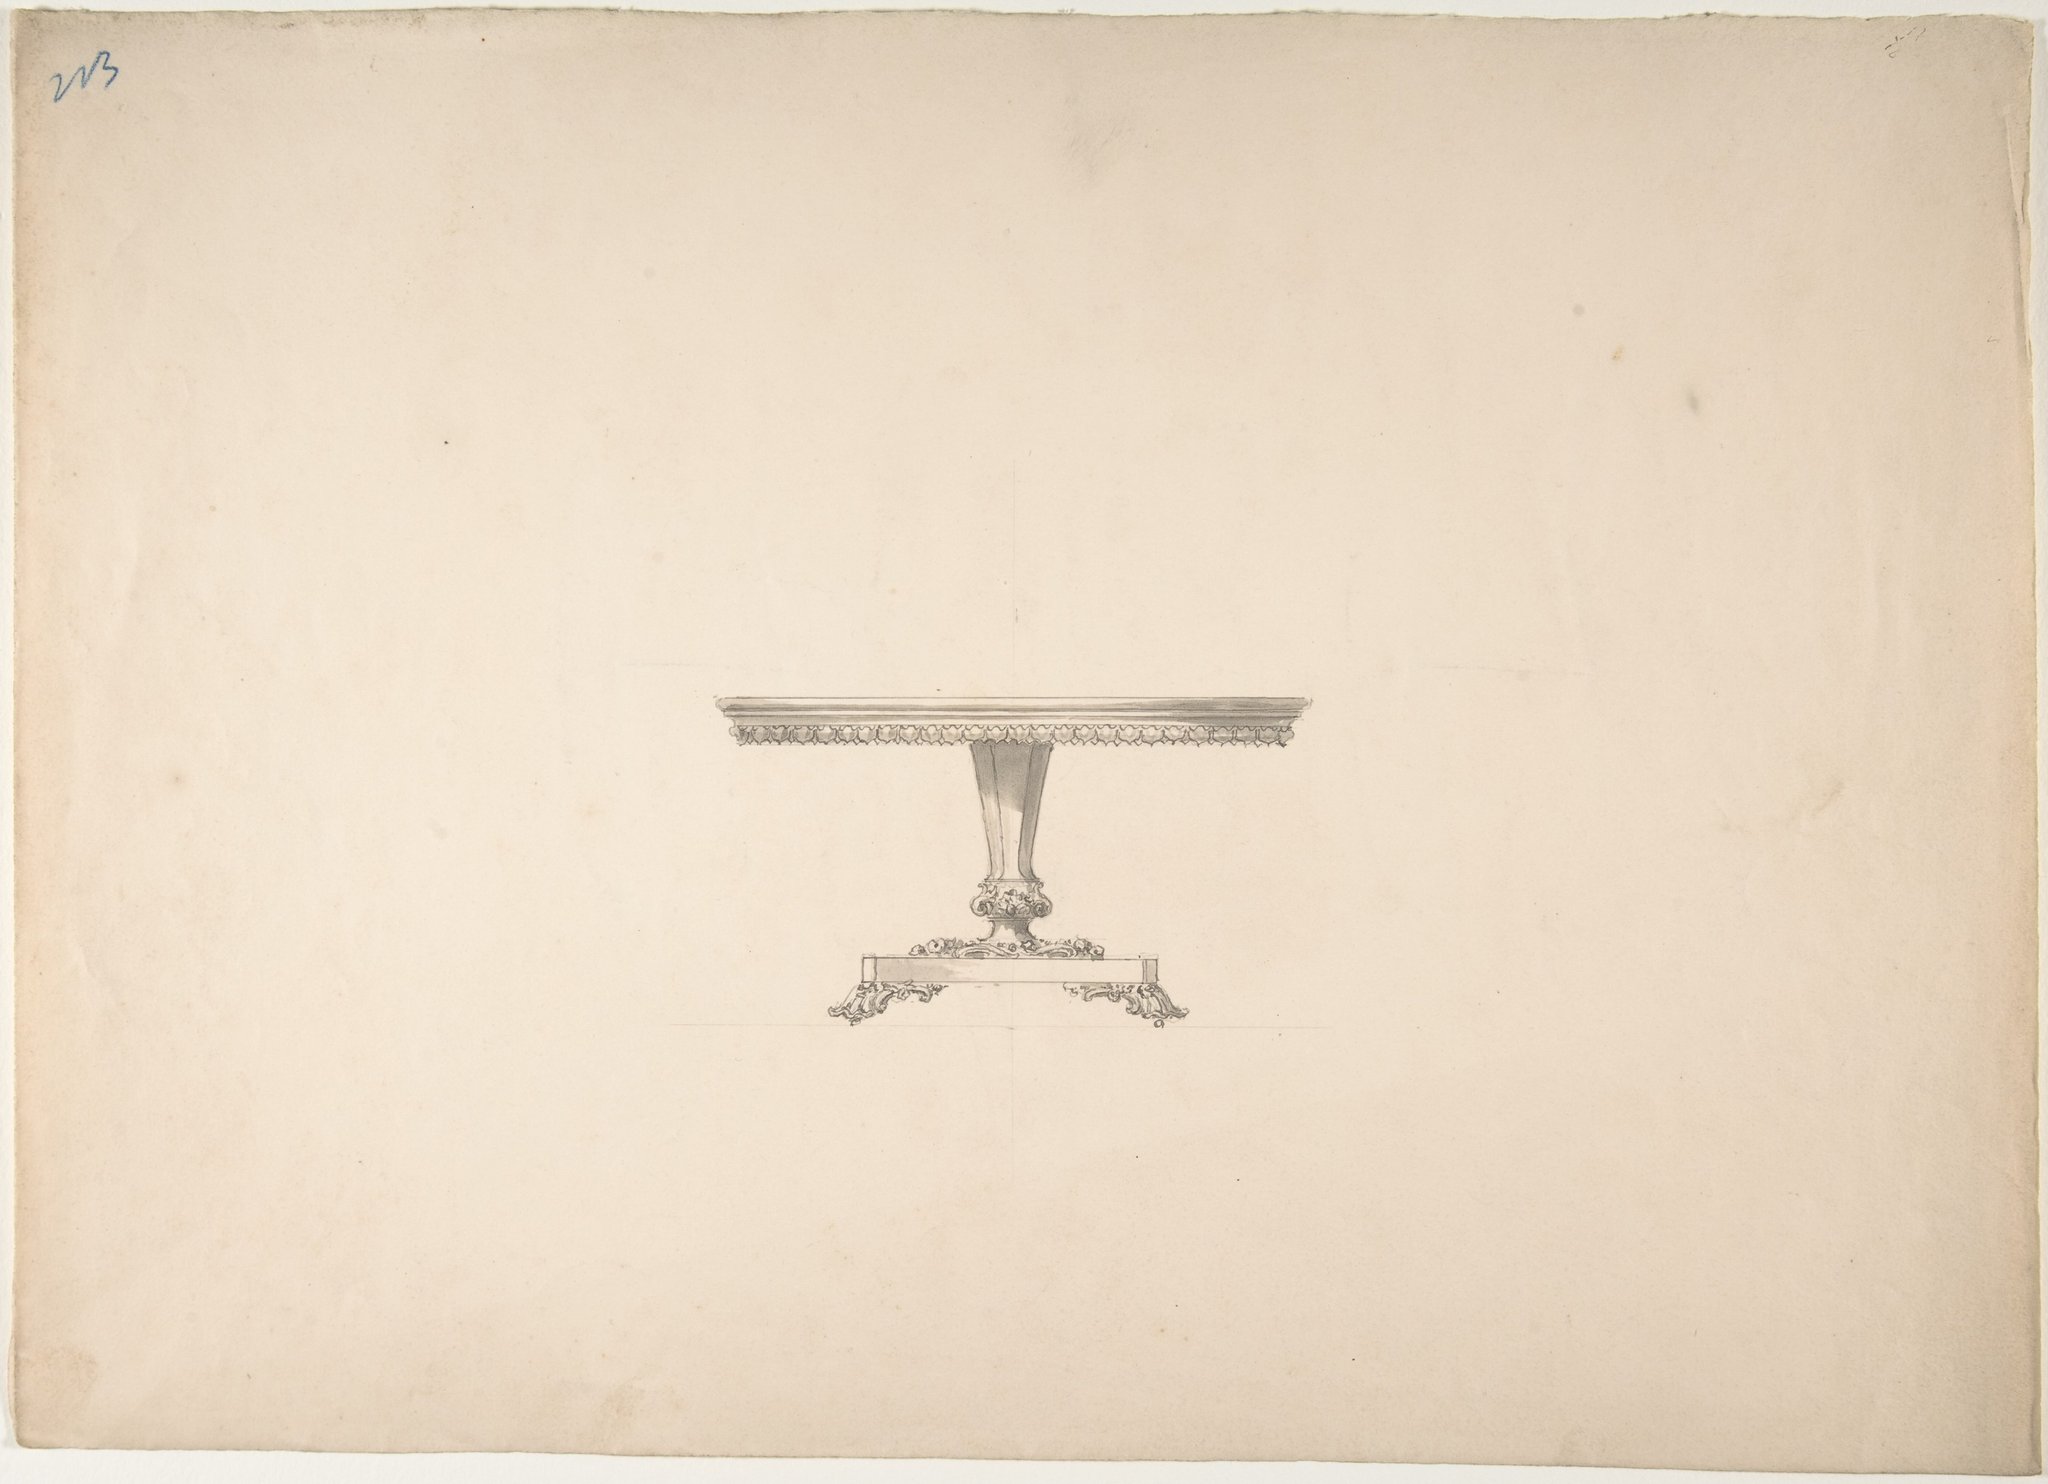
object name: drawing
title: Design for a Round Pedestal Table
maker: anonymous, british, 19th century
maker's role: artist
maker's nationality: british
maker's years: 1800-1900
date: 1801-1833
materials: graphite, ink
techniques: brush, pen, wash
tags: tables